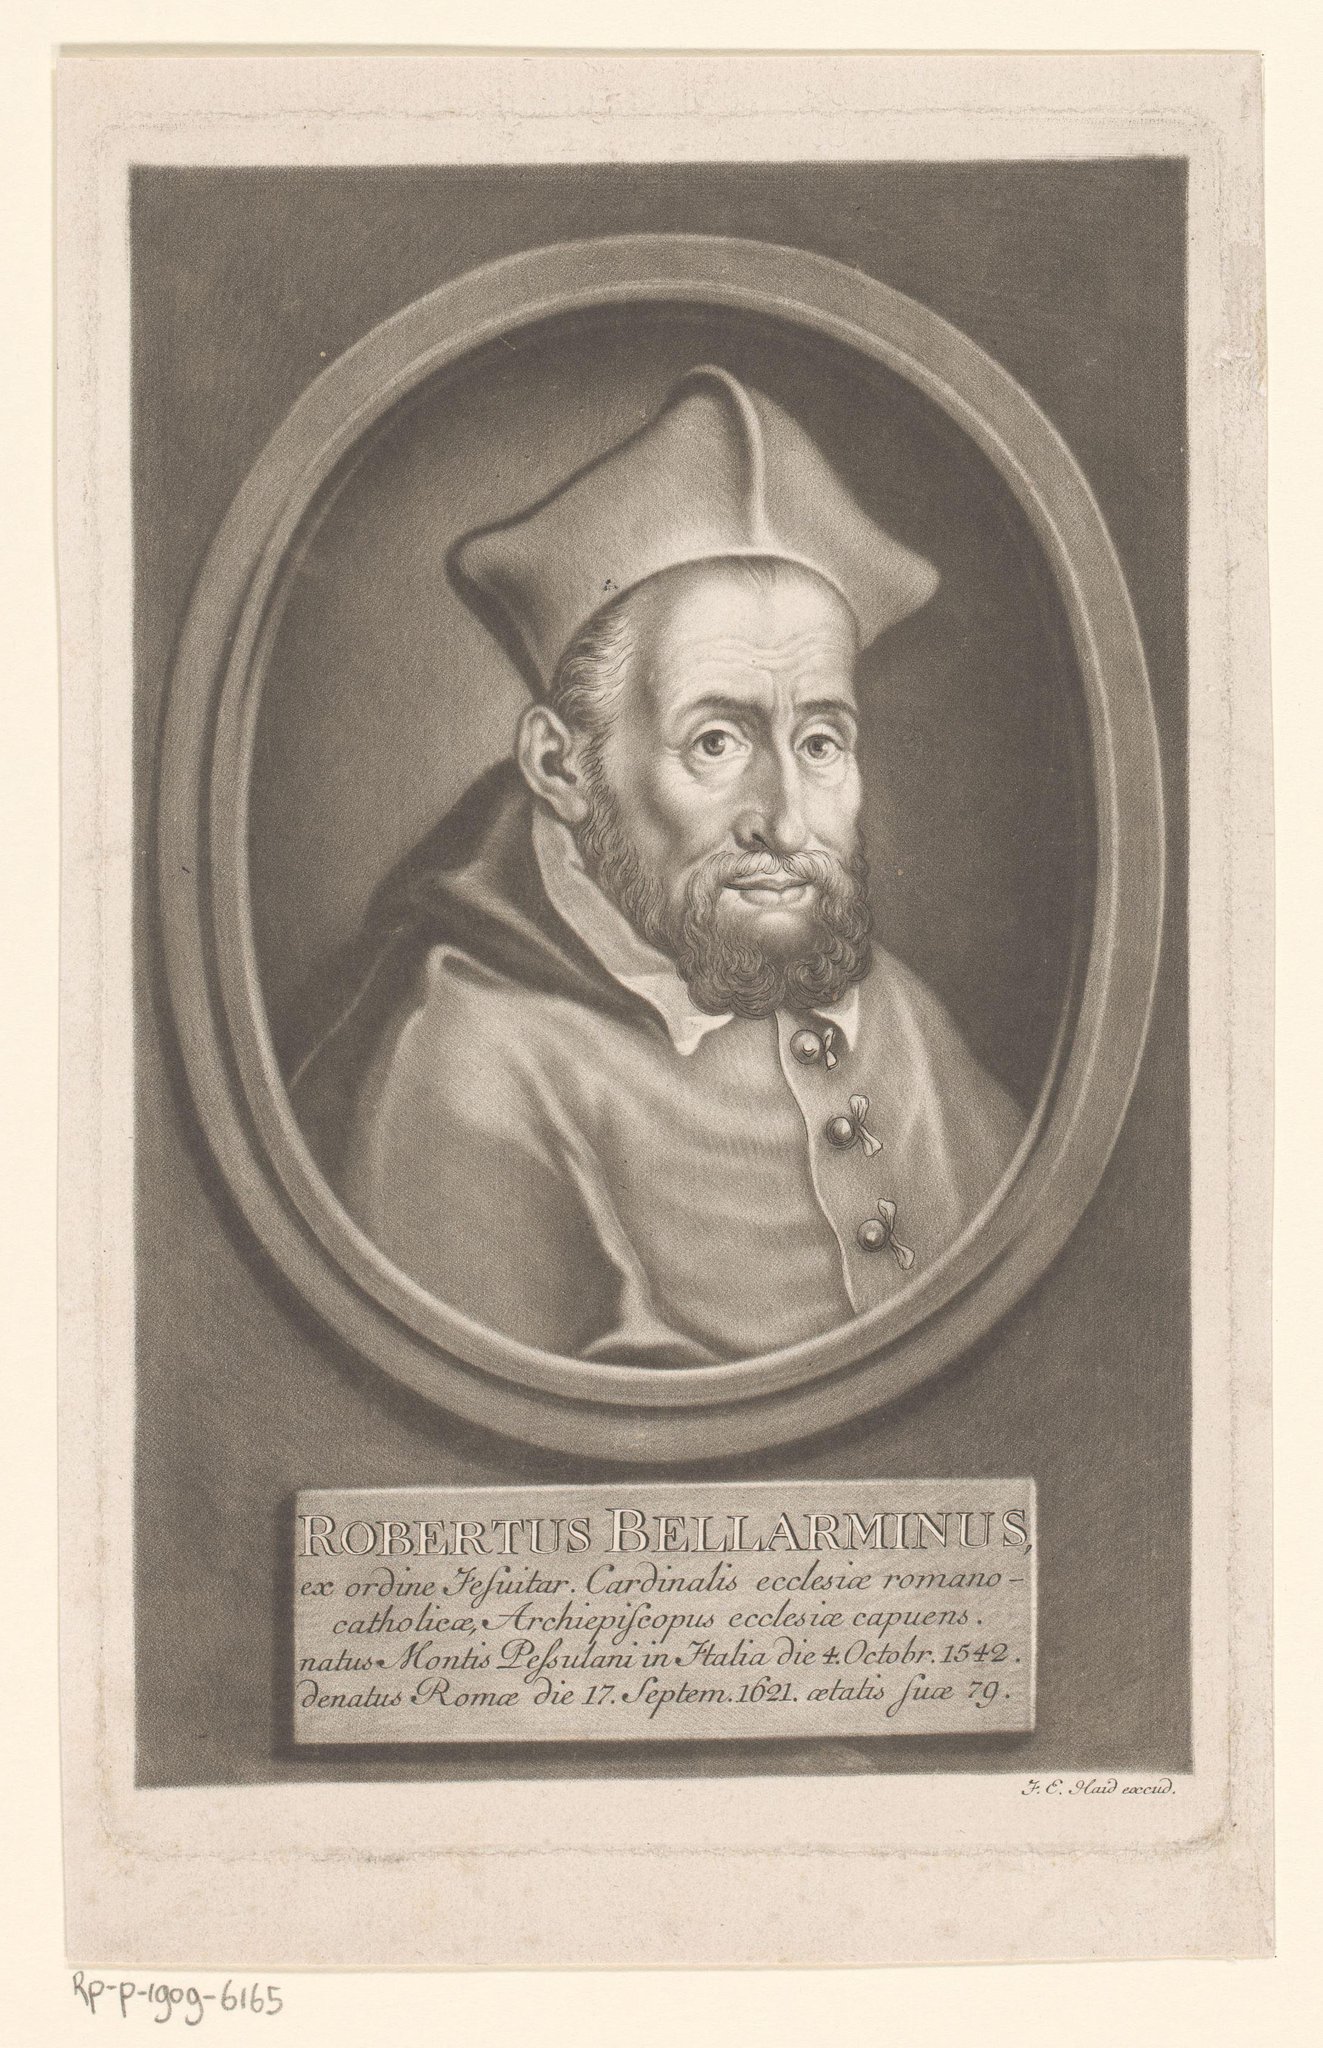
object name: print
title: Portret van Roberto Bellarmino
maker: johann elias haid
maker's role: print maker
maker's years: 1739-1809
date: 1749-1809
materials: paper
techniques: engraving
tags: rome, cardinal, historical persons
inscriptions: collector's mark: Lugt 2228